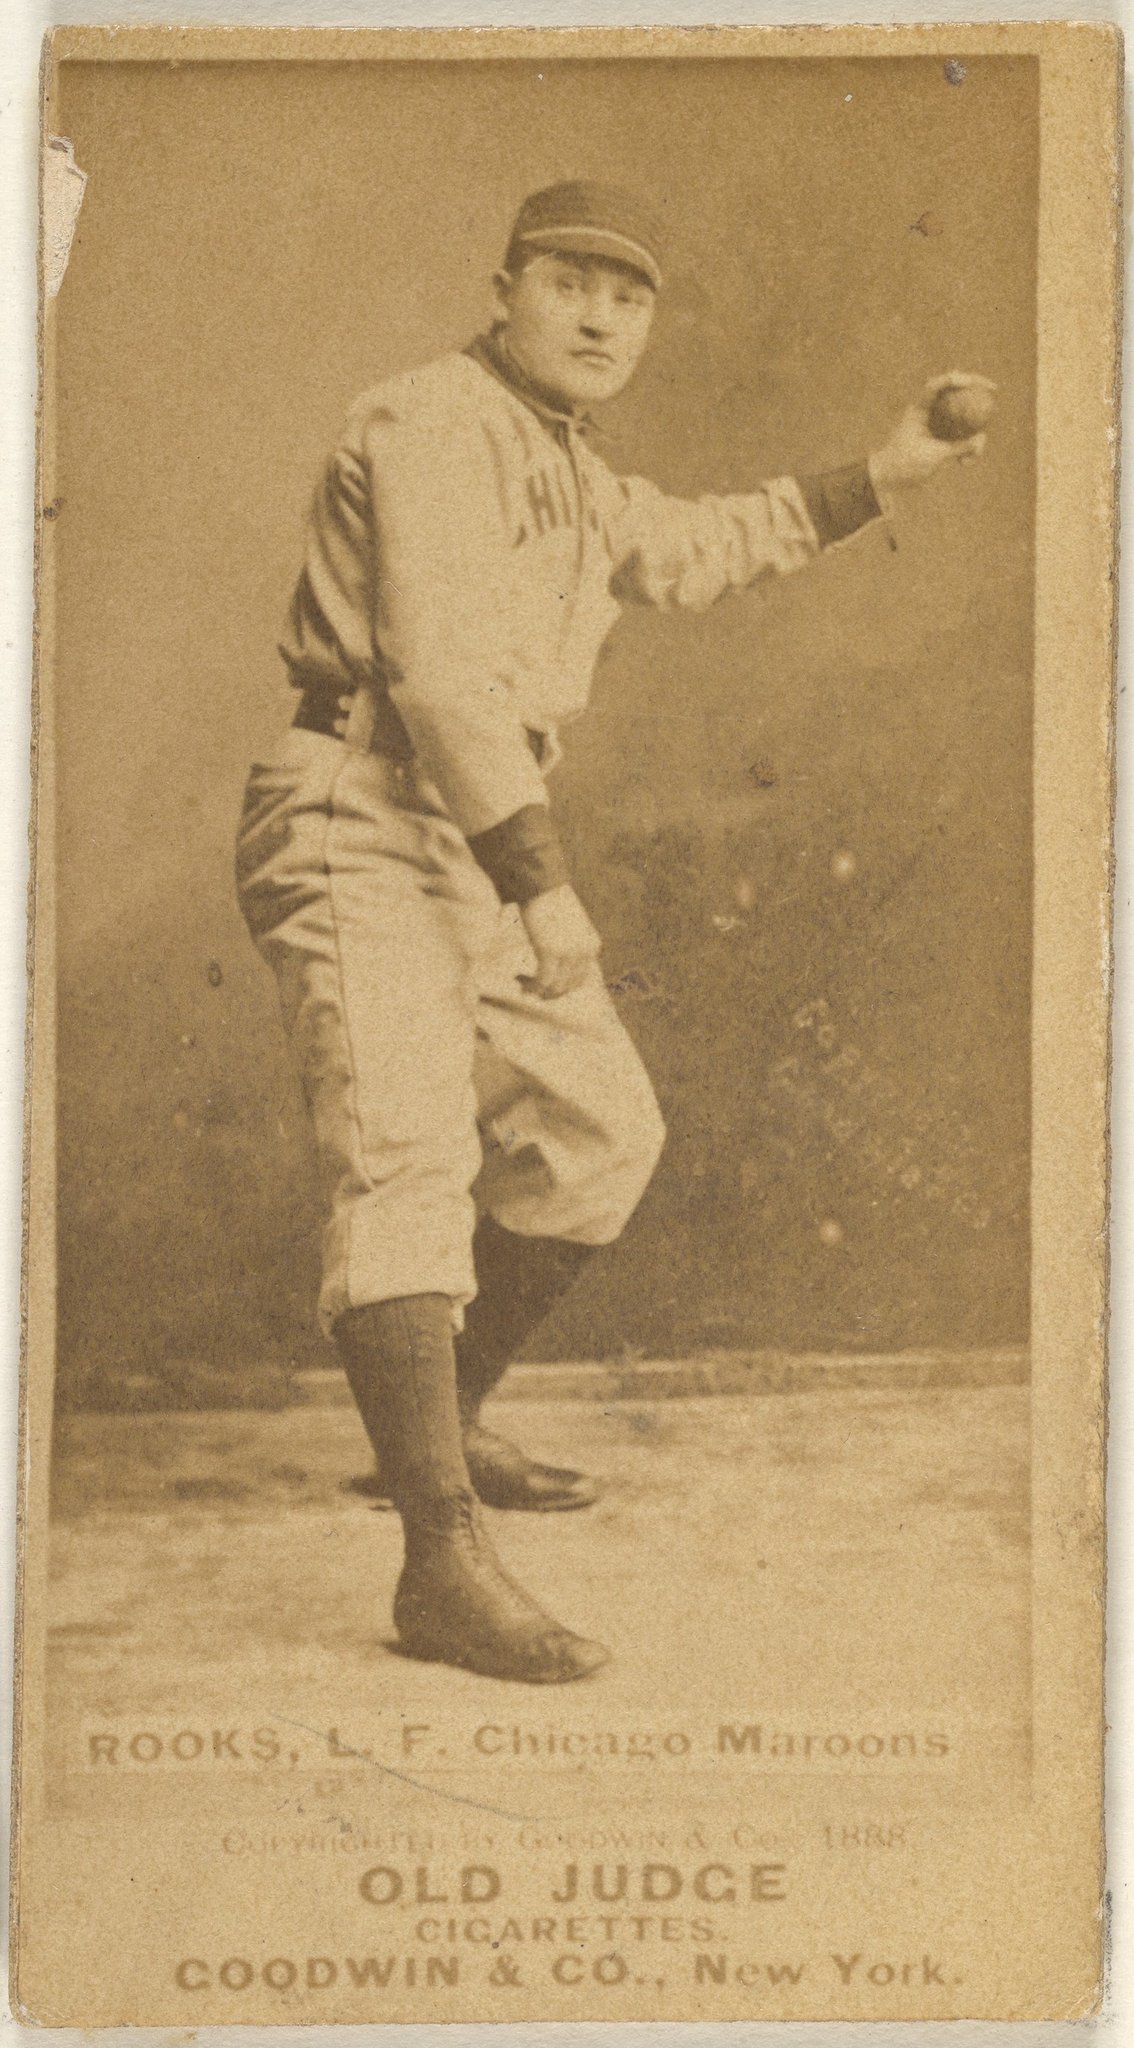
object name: baseball card, photograph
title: Rooks, Left Field, Chicago, from the Old Judge series (N172) for Old Judge Cigarettes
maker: goodwin & company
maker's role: publisher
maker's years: 1850-1950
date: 1888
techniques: albumen silver print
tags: men,portraits,baseball,athletes